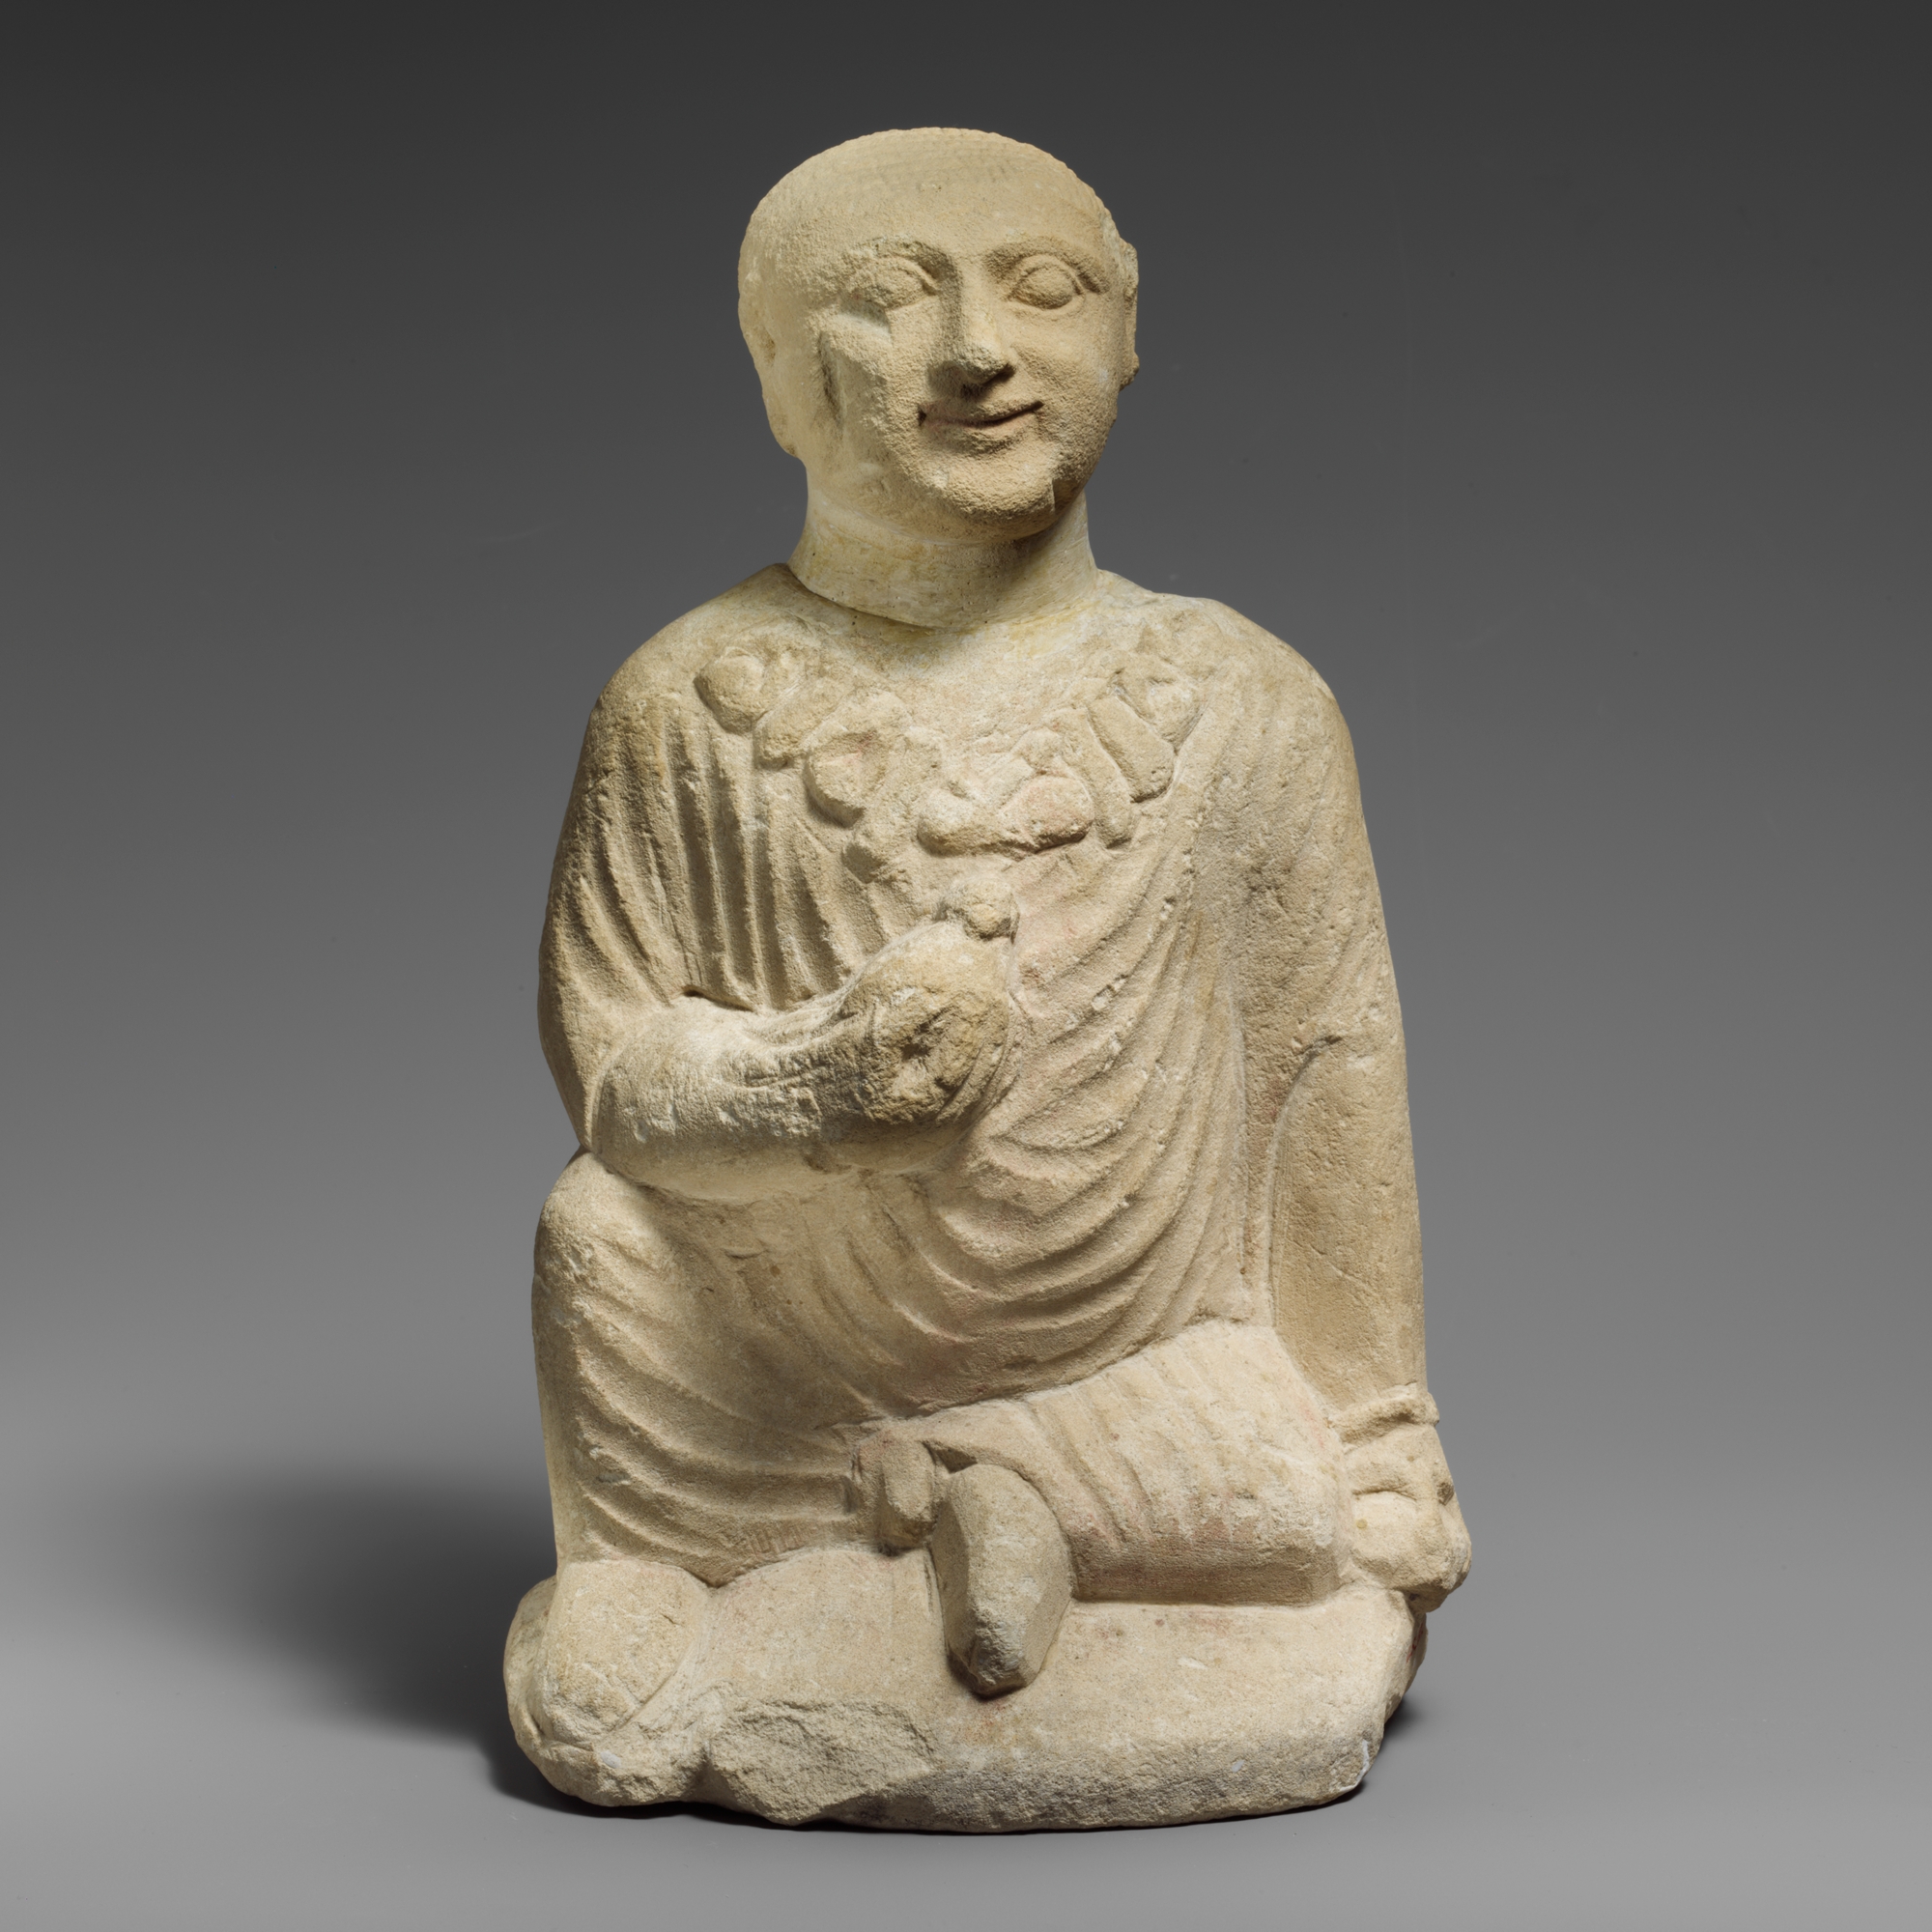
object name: statuette of a temple boy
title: Limestone statuette of a temple boy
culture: cypriot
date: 400-301 BCE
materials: limestone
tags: boys